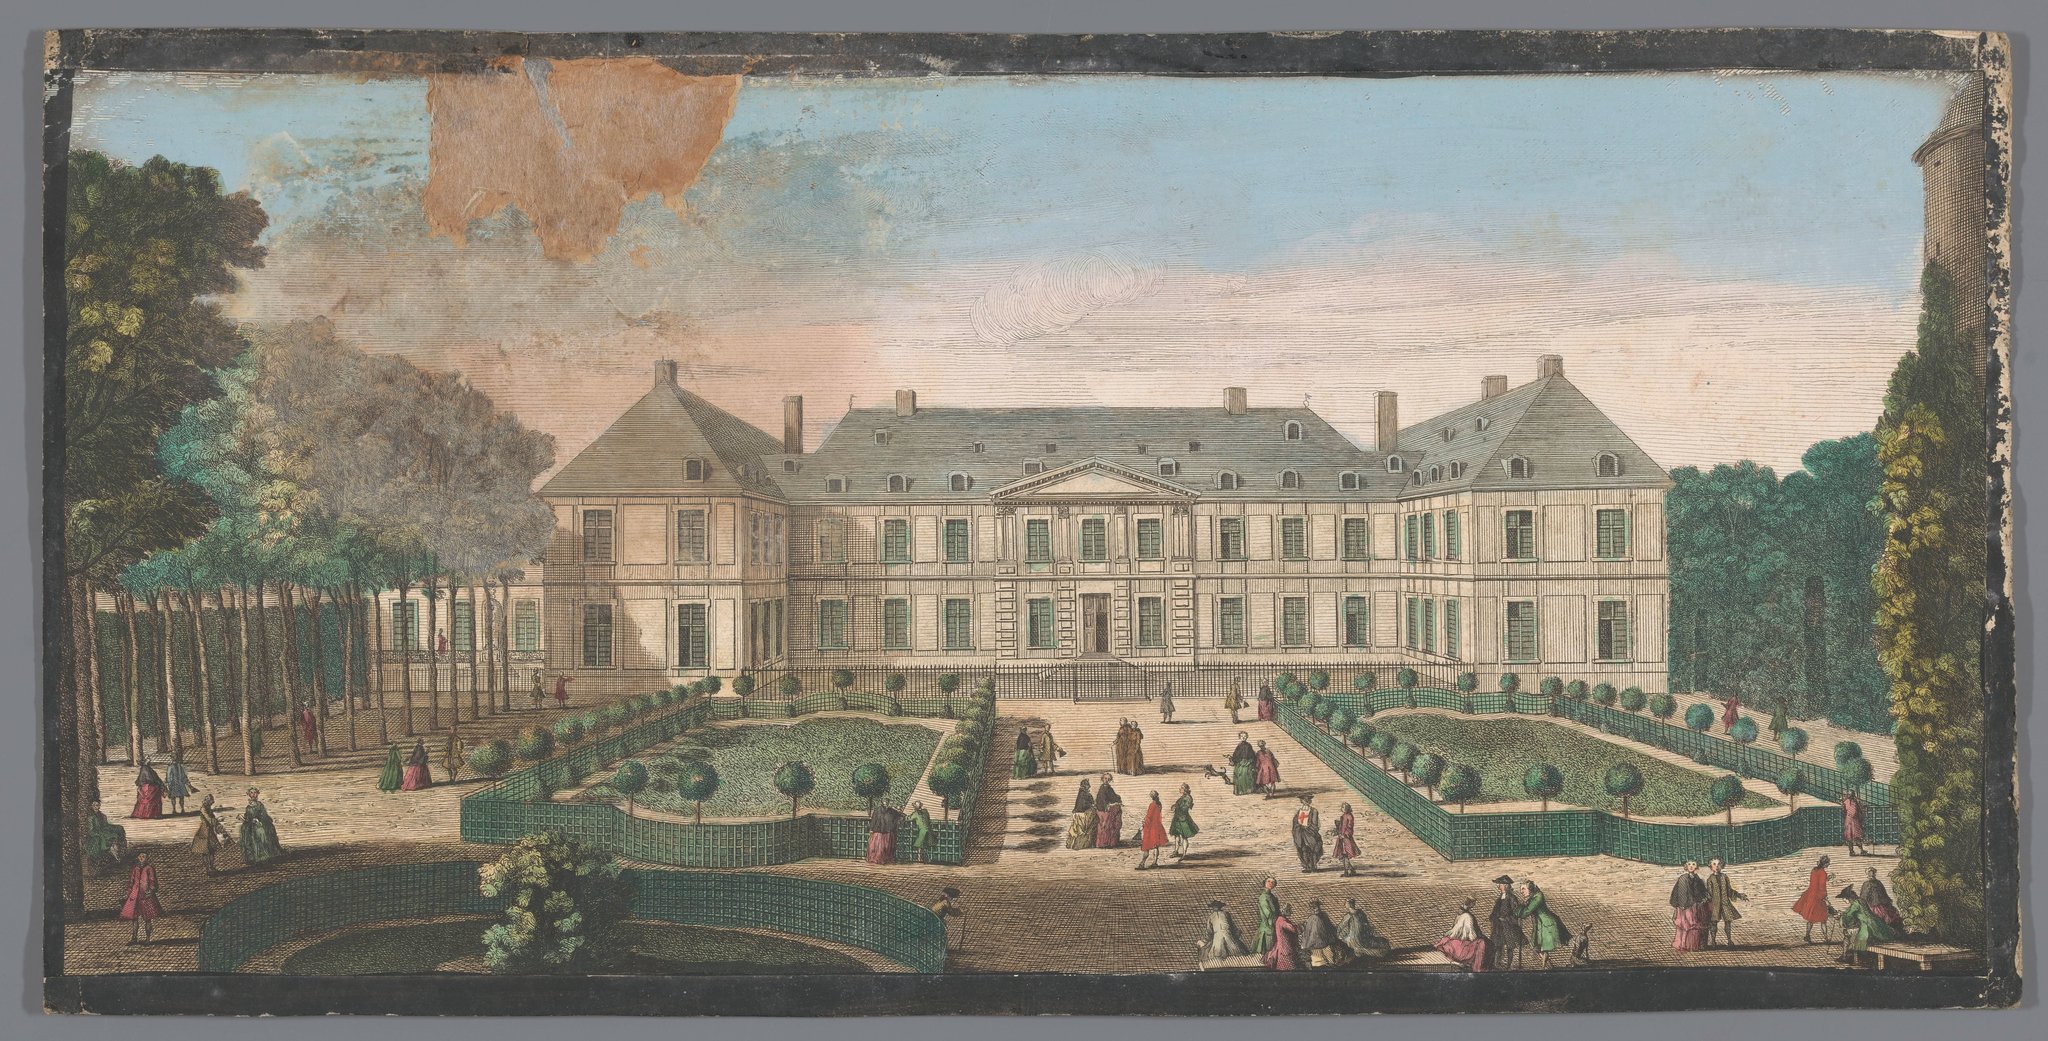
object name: opticaprent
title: Autre vuë du Palais du Temple du côté du jardin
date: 1700-1799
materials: cardboard, paper, watercolor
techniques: brush, etching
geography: paris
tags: garden, ornamental plants, palace